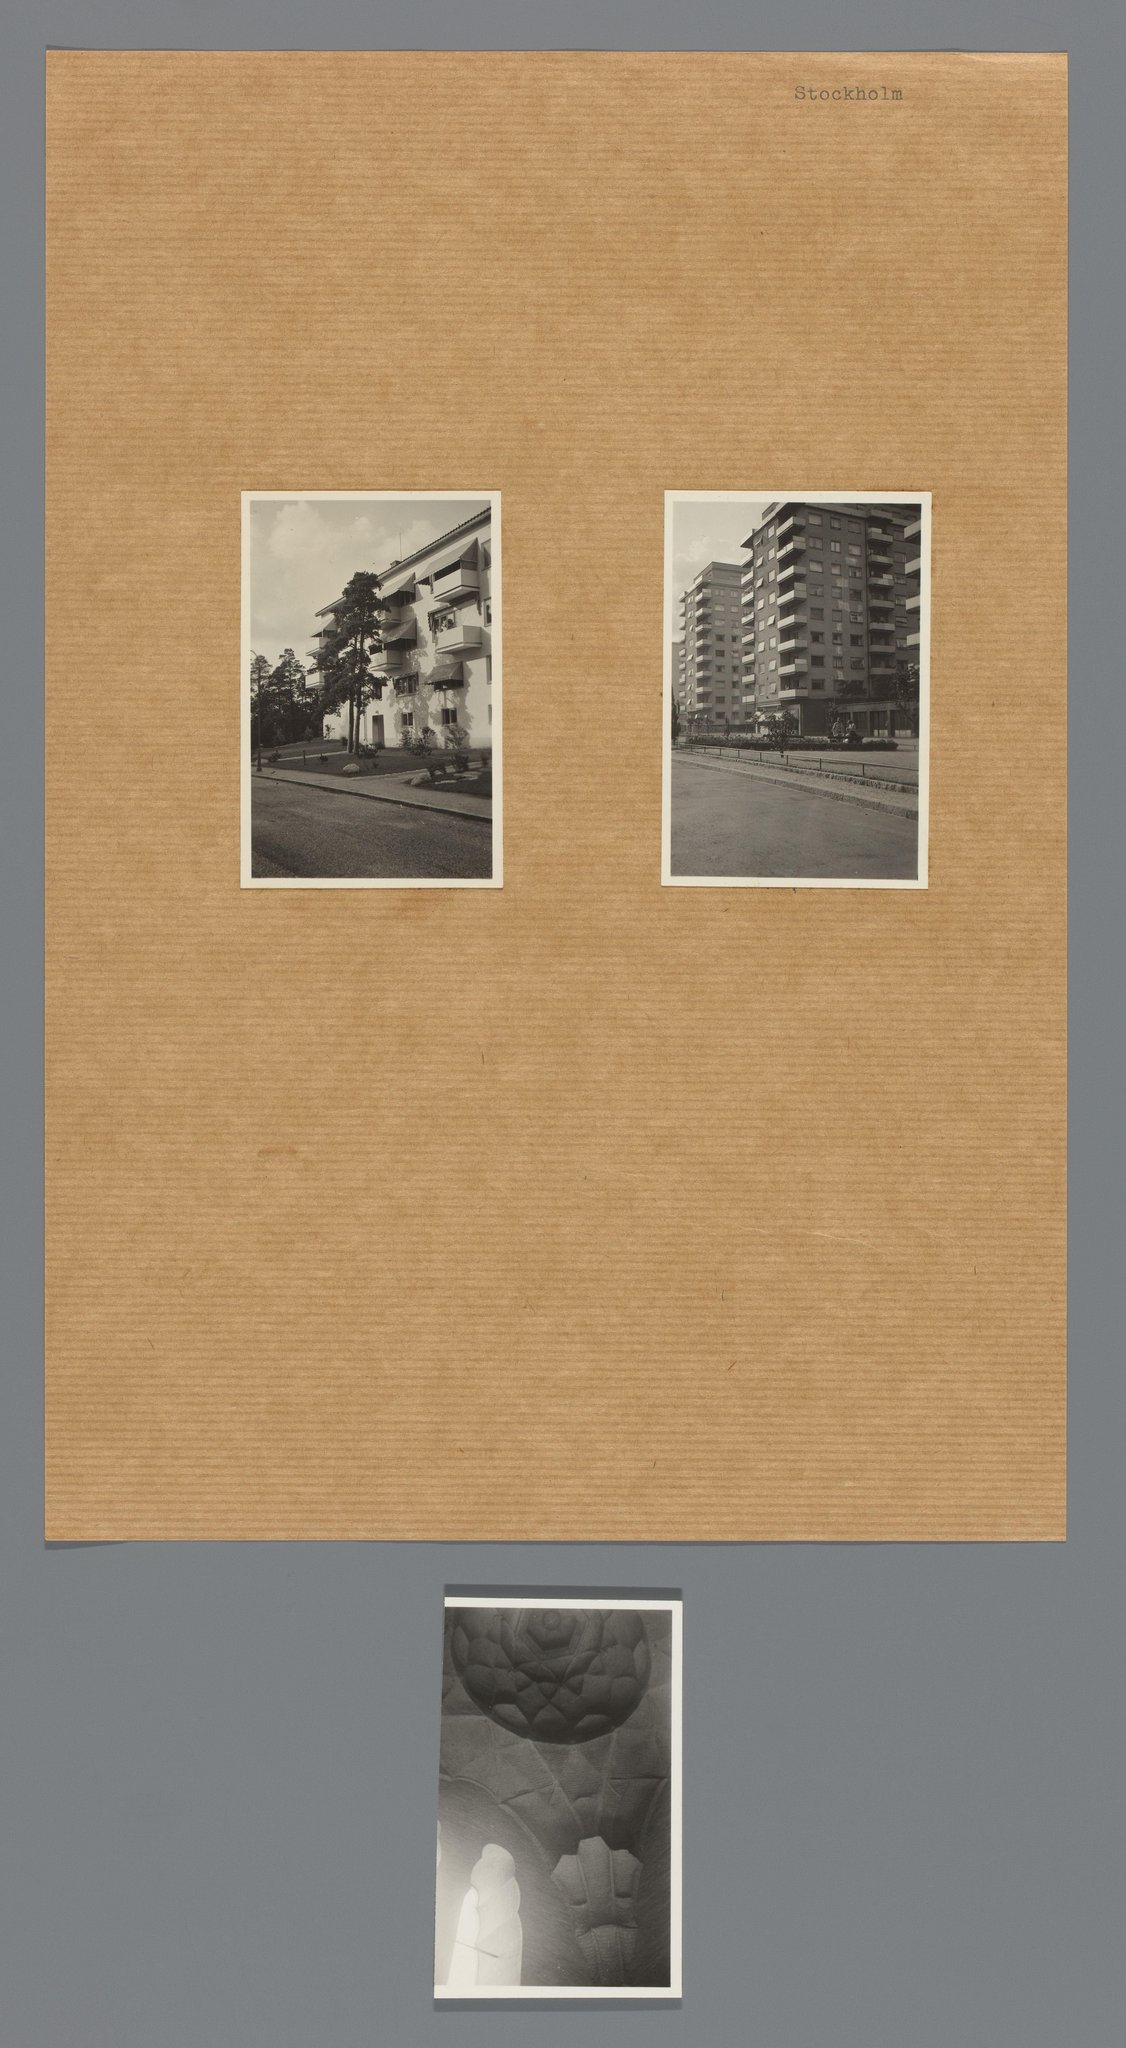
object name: photograph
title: Stockholm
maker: Anonymous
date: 1880-1920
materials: photographic support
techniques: gelatin silver print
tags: stockholm